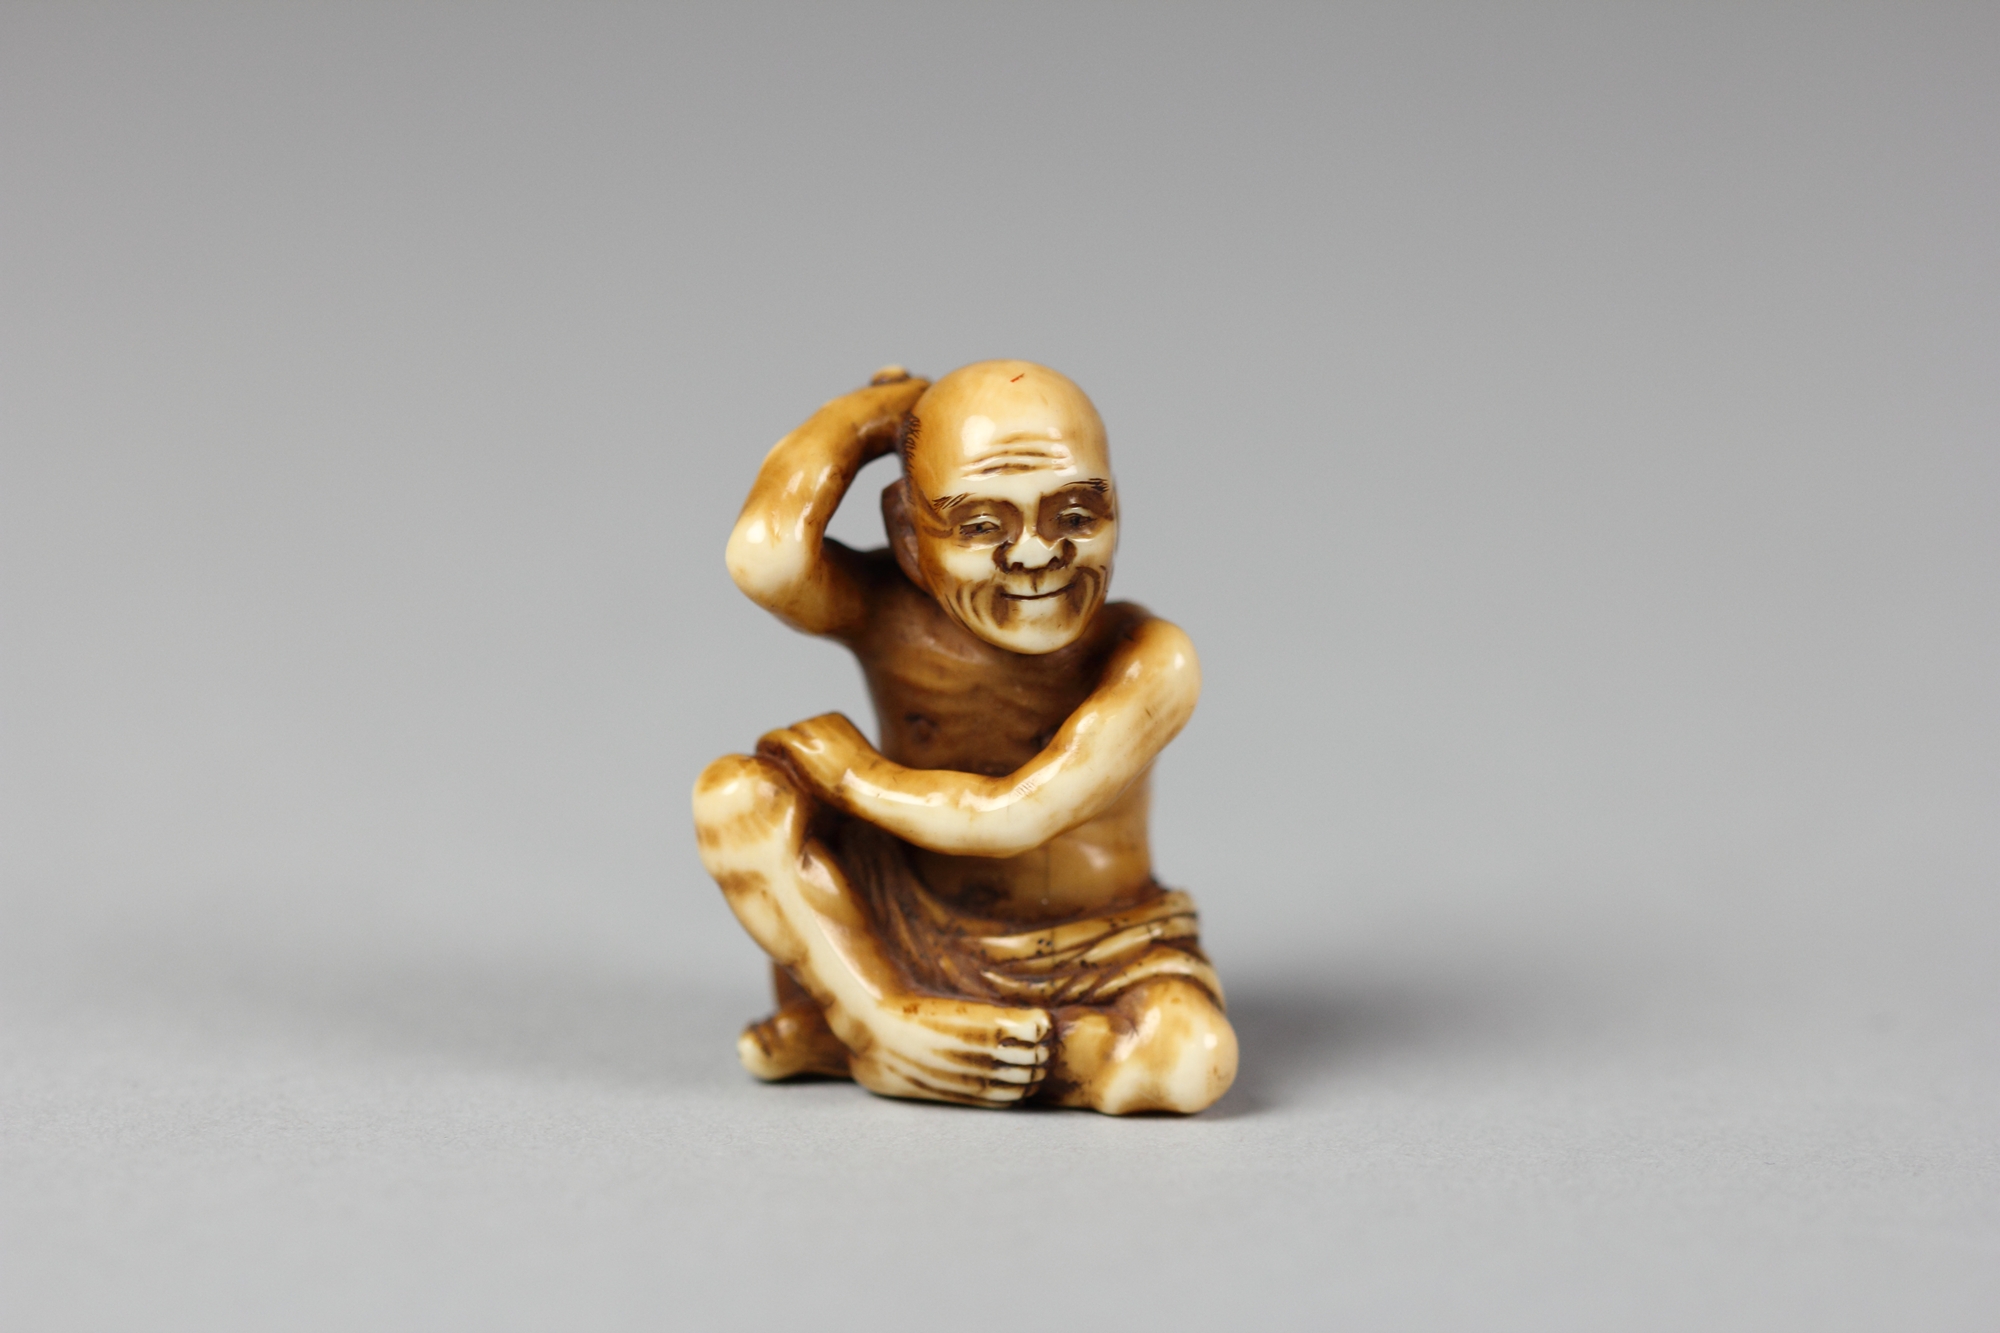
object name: netsuke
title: Netsuke of Figure of a Man Scratching His Back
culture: japanese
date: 1801-1900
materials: ivory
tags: men